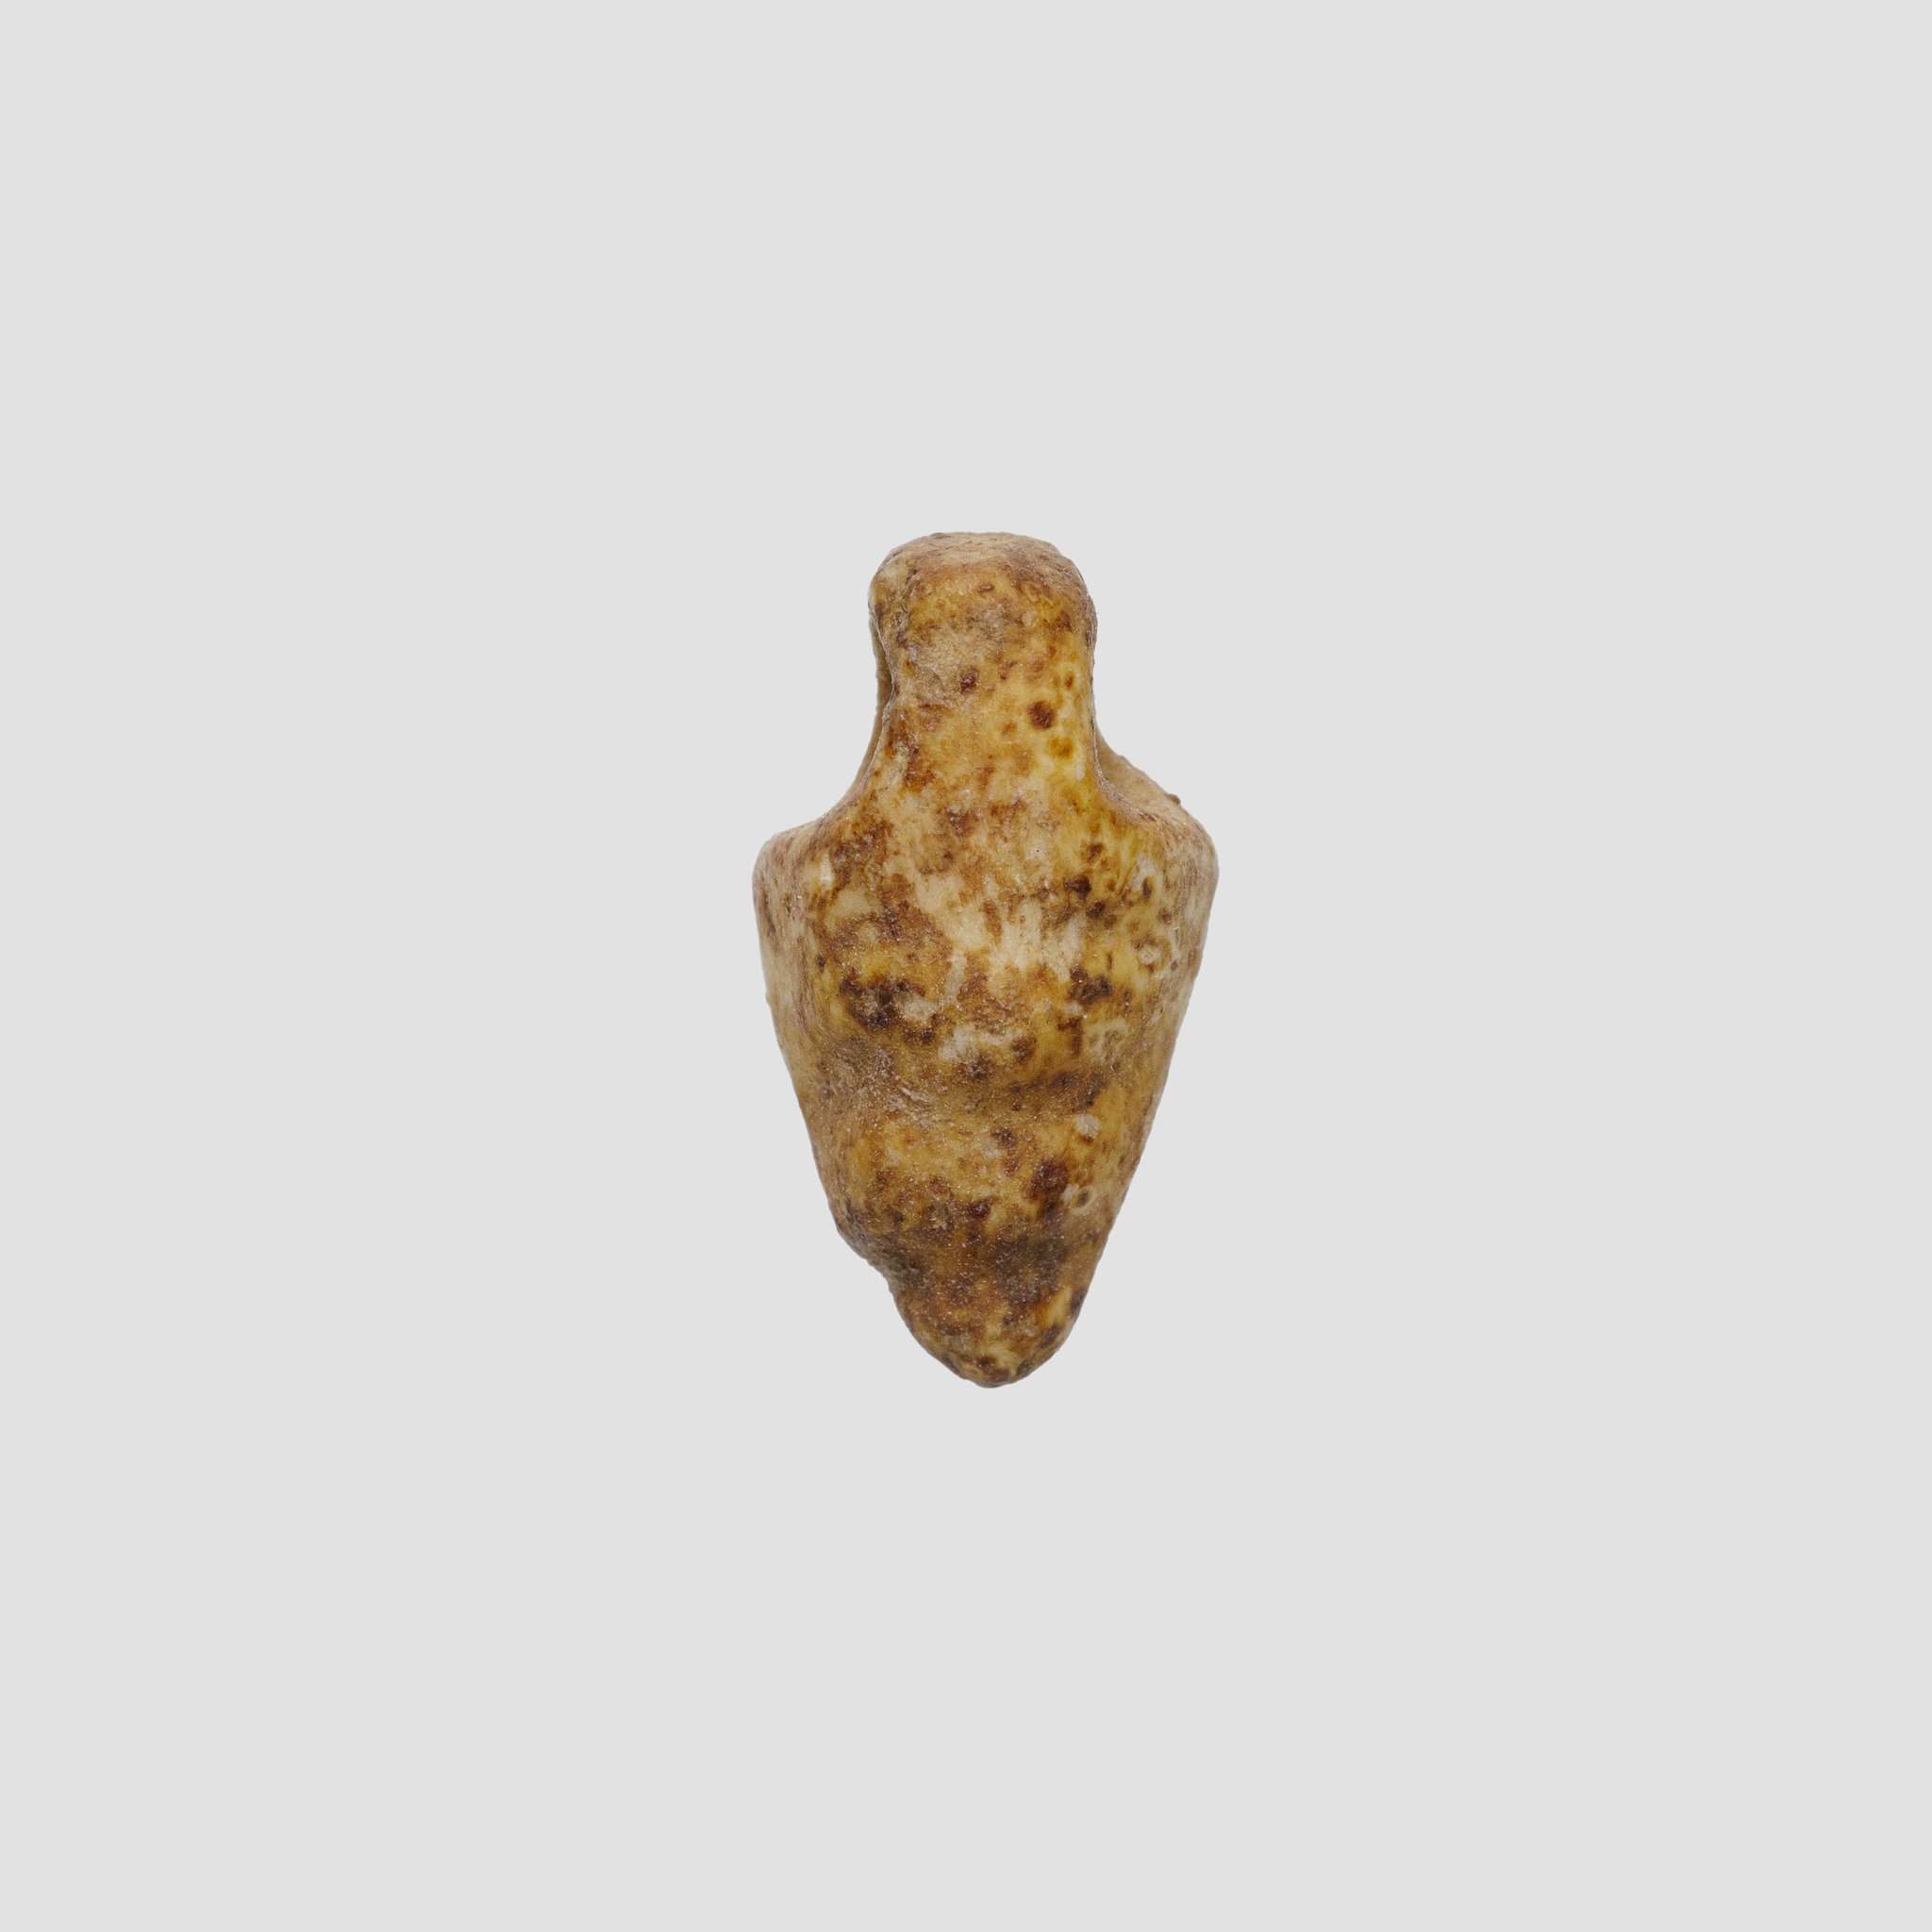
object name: amulet, shell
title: Shell (?) amulet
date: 2150-1950 BCE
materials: bone, ivory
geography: egypt